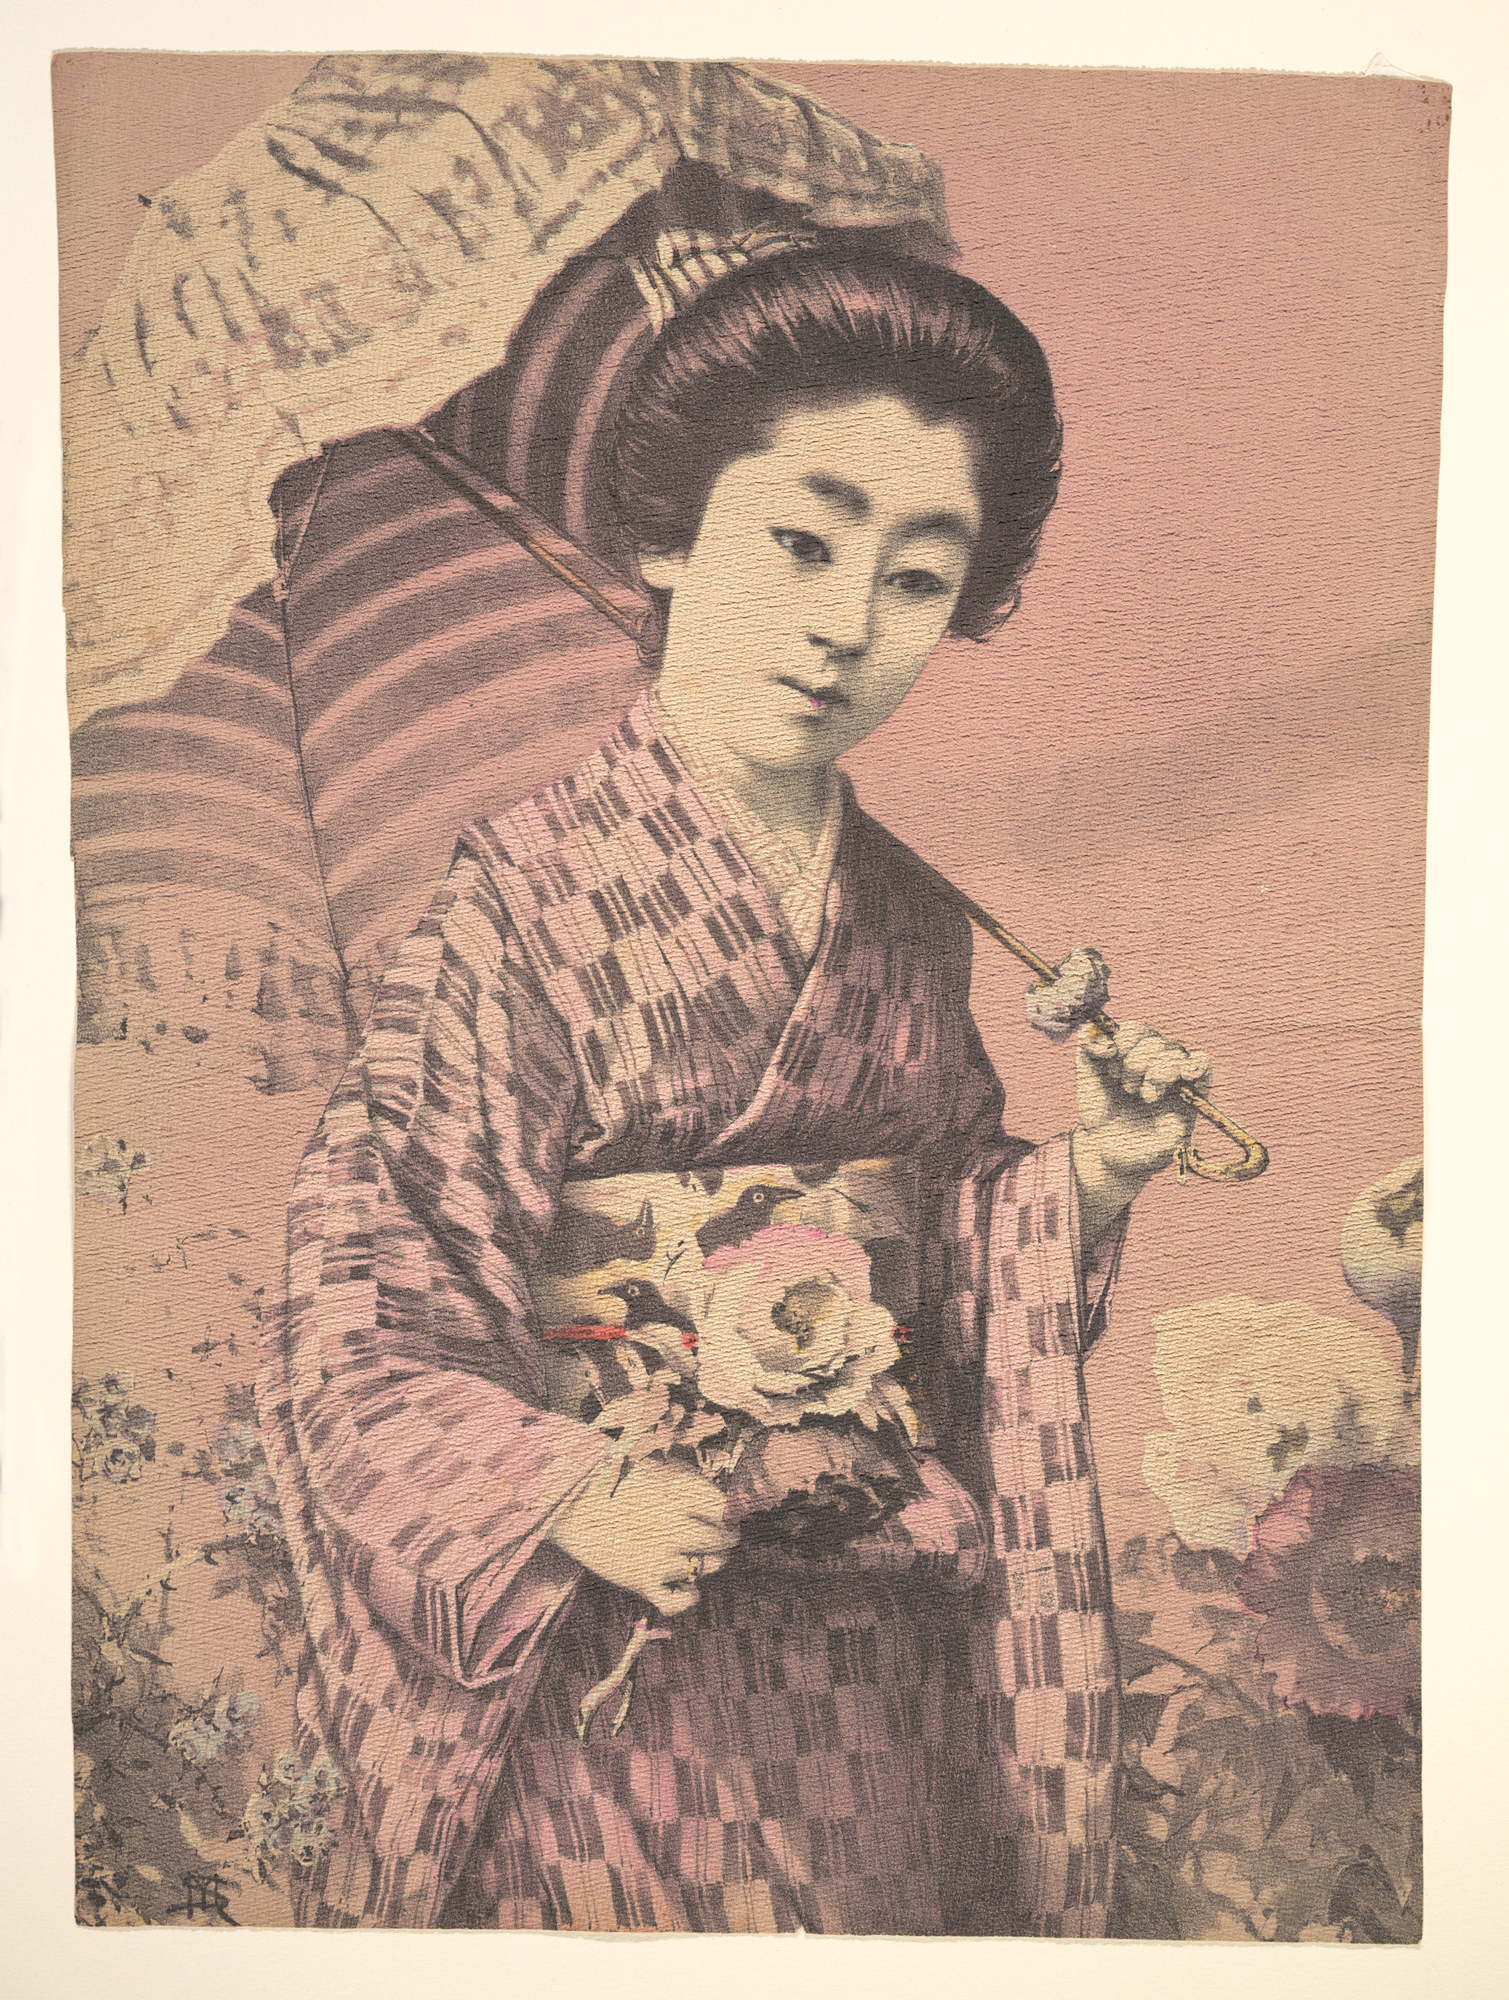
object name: print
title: Girl Carrying a Parasol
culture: japanese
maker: unidentified artist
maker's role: artist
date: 1901-1933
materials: ink, paper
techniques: woodblock print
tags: girls,parasols